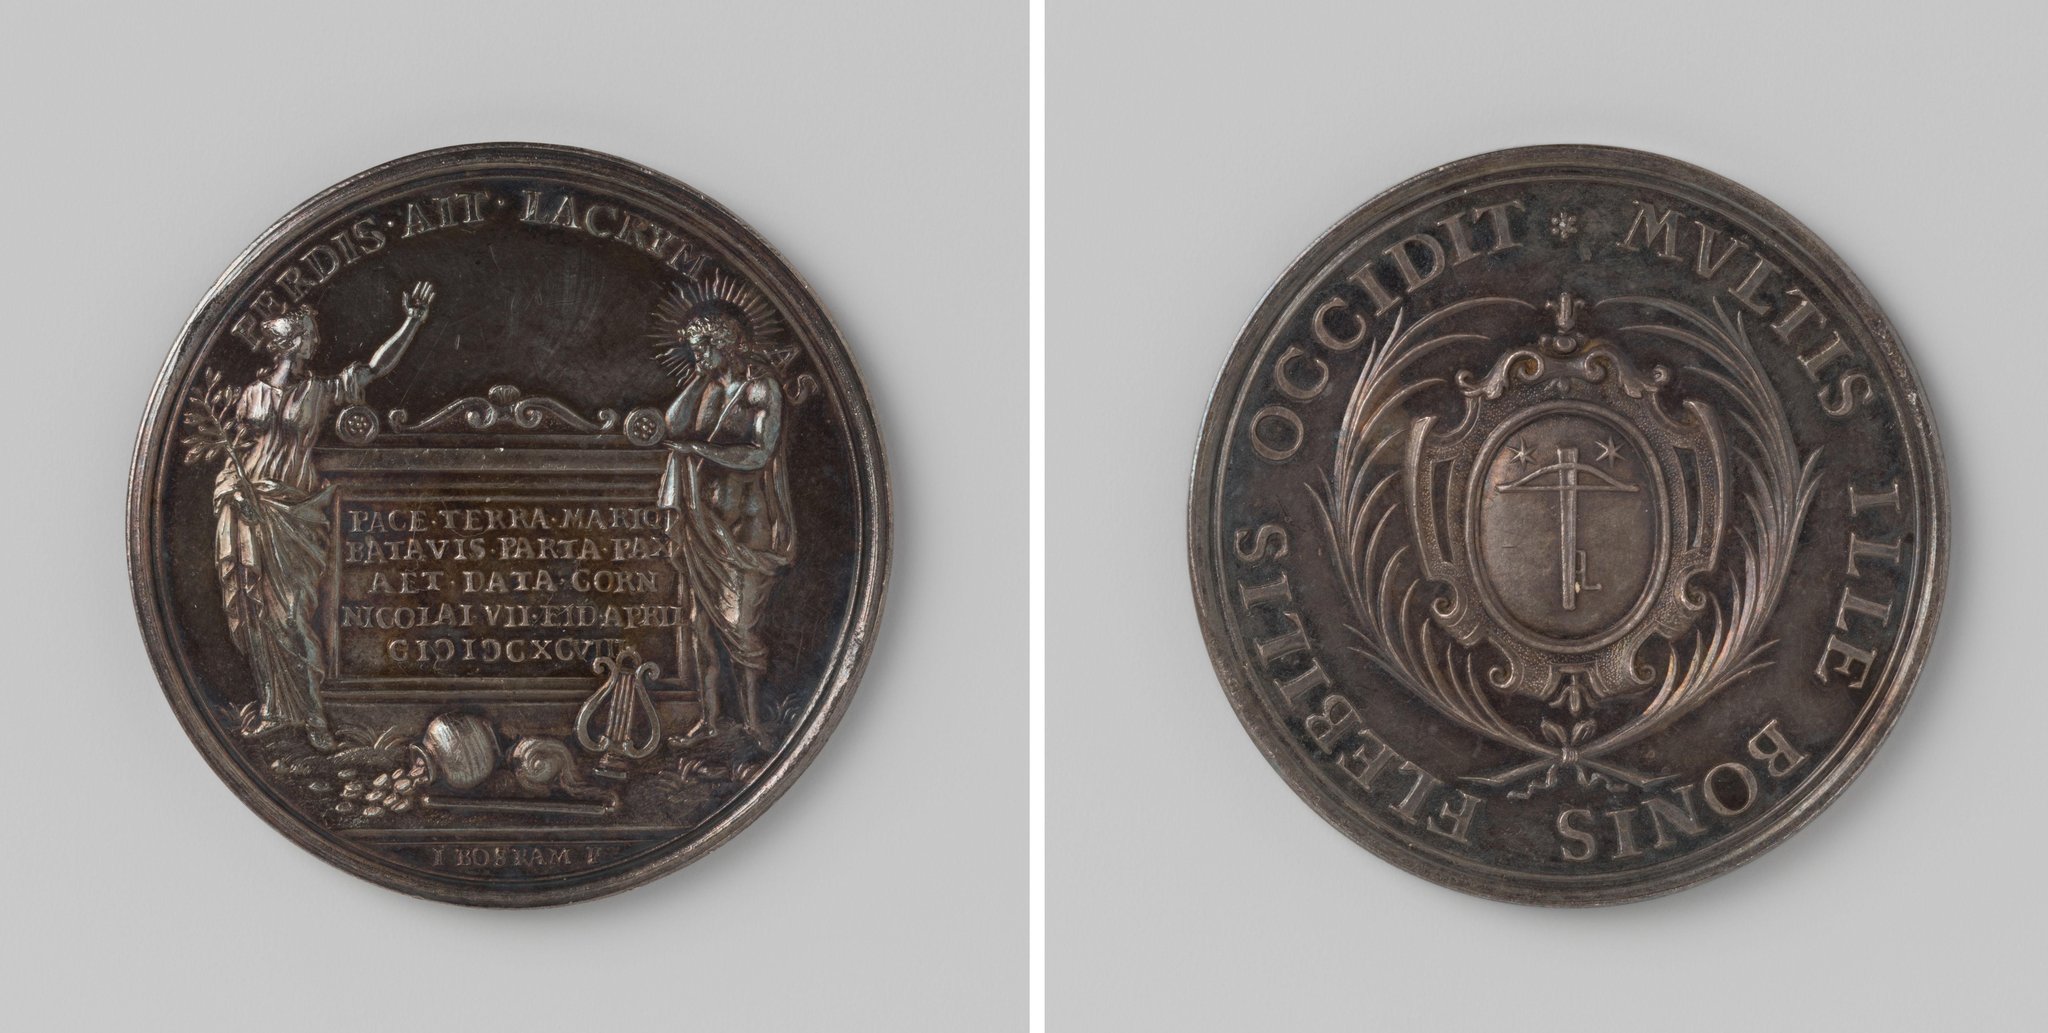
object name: family medal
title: Overlijden van de muntverzamelaar Cornelis Nicolai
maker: jan boskam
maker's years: 1687-1708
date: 1698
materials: silver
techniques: striking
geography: nijmegen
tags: cornelis nicolai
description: Zilveren penning. Voorzijde: vrouw met olijftak en man met stralenkrans staande bij graf met opschrift, op grond omgekeerde pot met geld en lier binnen omschrift; afsnede: signatuur. Keerzijde: wapenschild binnen omschrift